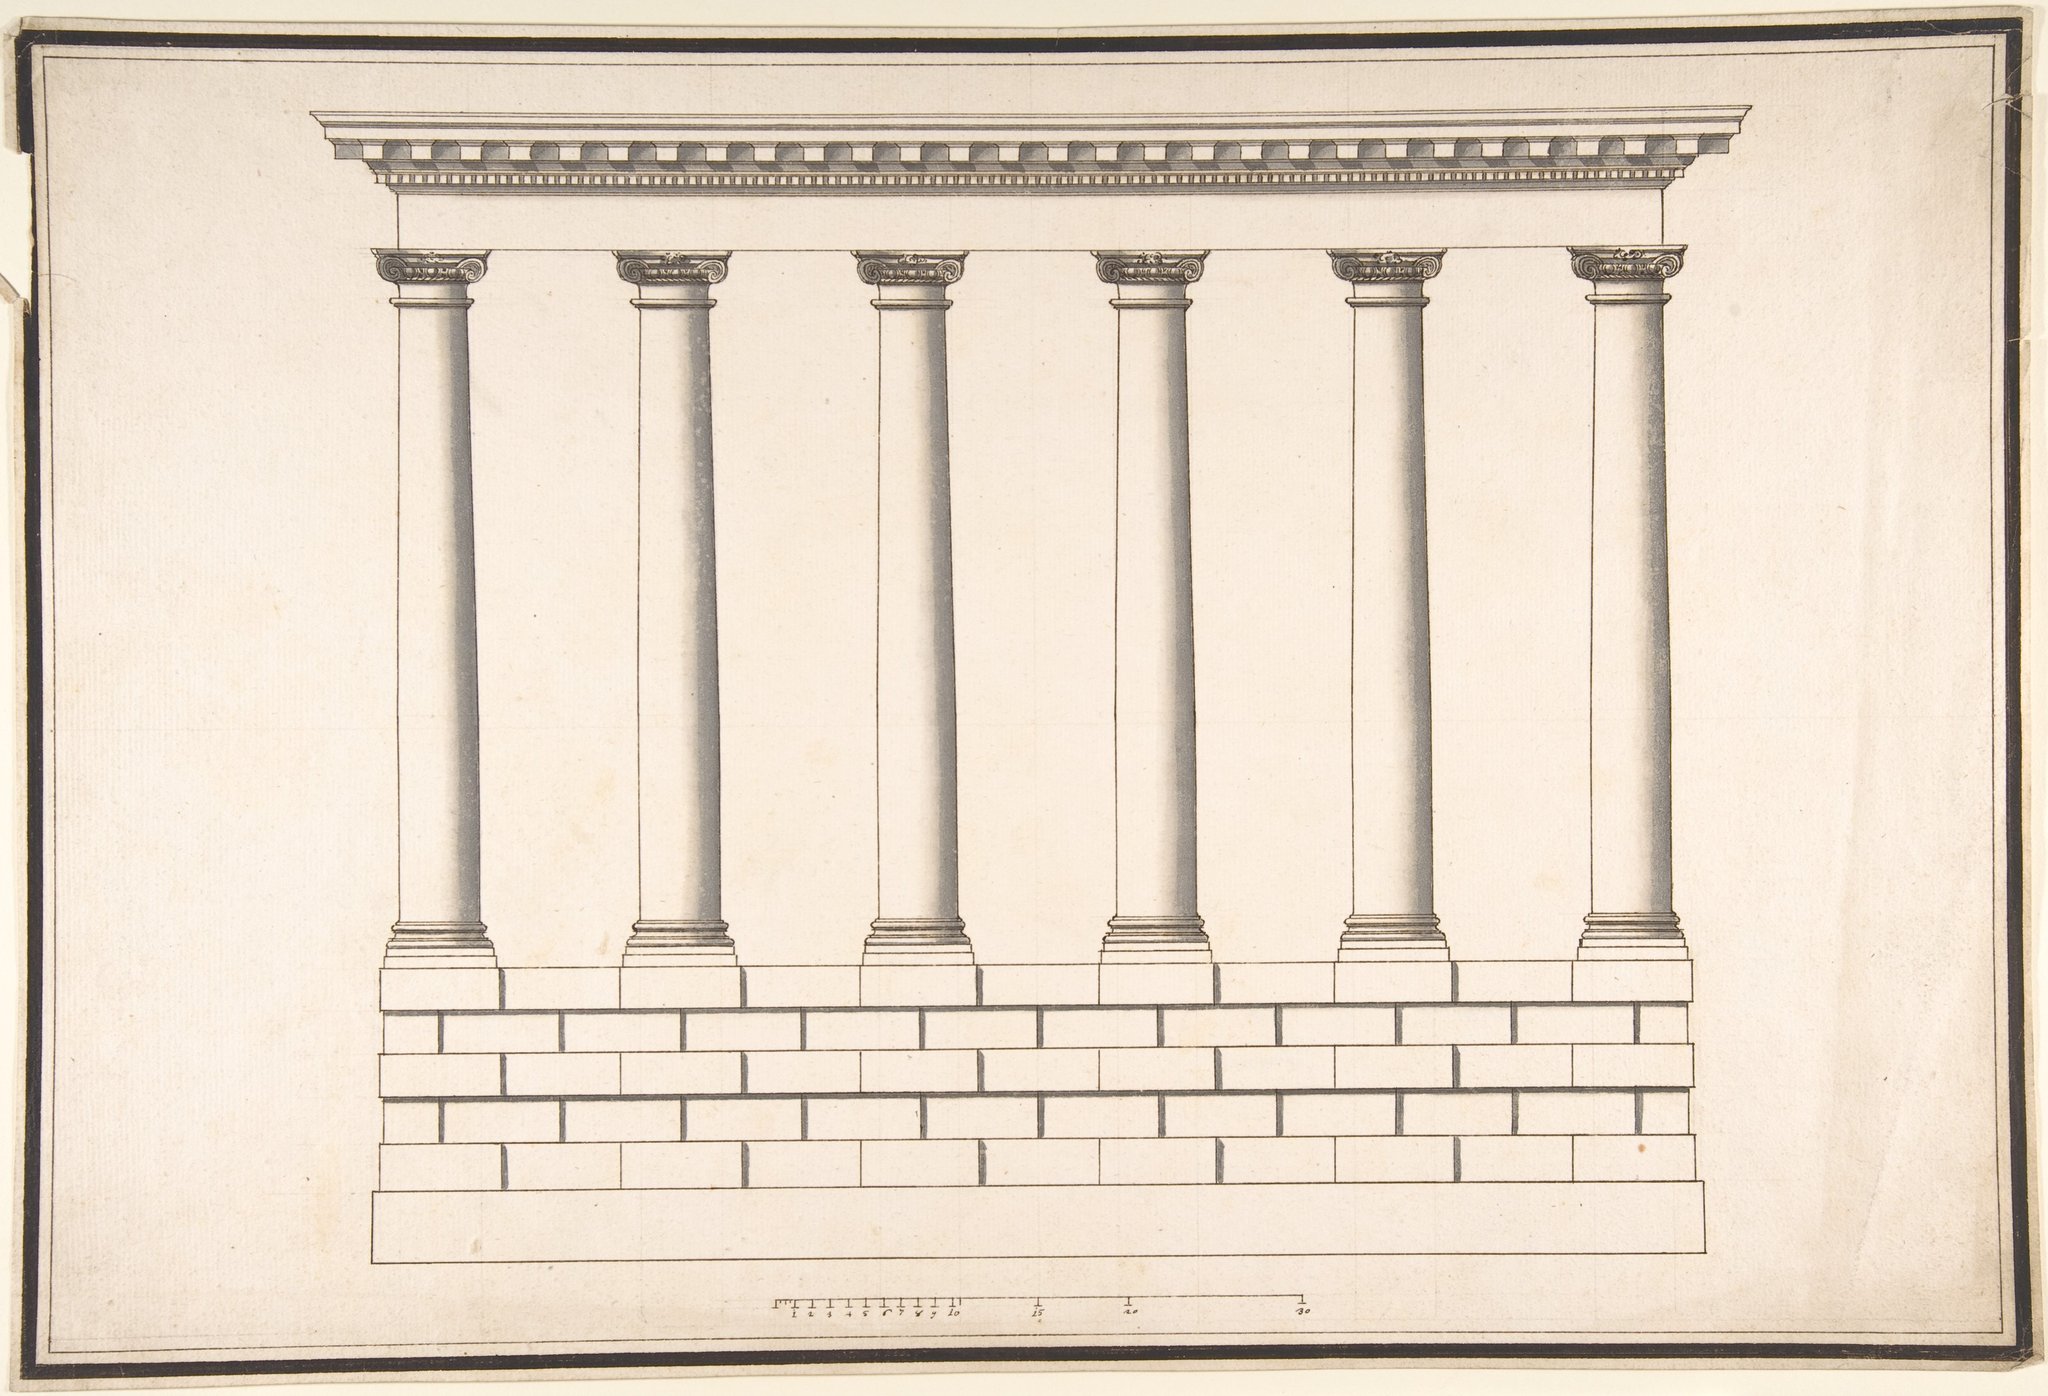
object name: drawing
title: Ionic Colonnade (6 Columns) on Rusticated Base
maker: antonio visentini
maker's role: artist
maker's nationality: italian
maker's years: 1688-1782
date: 1688-1782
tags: columns